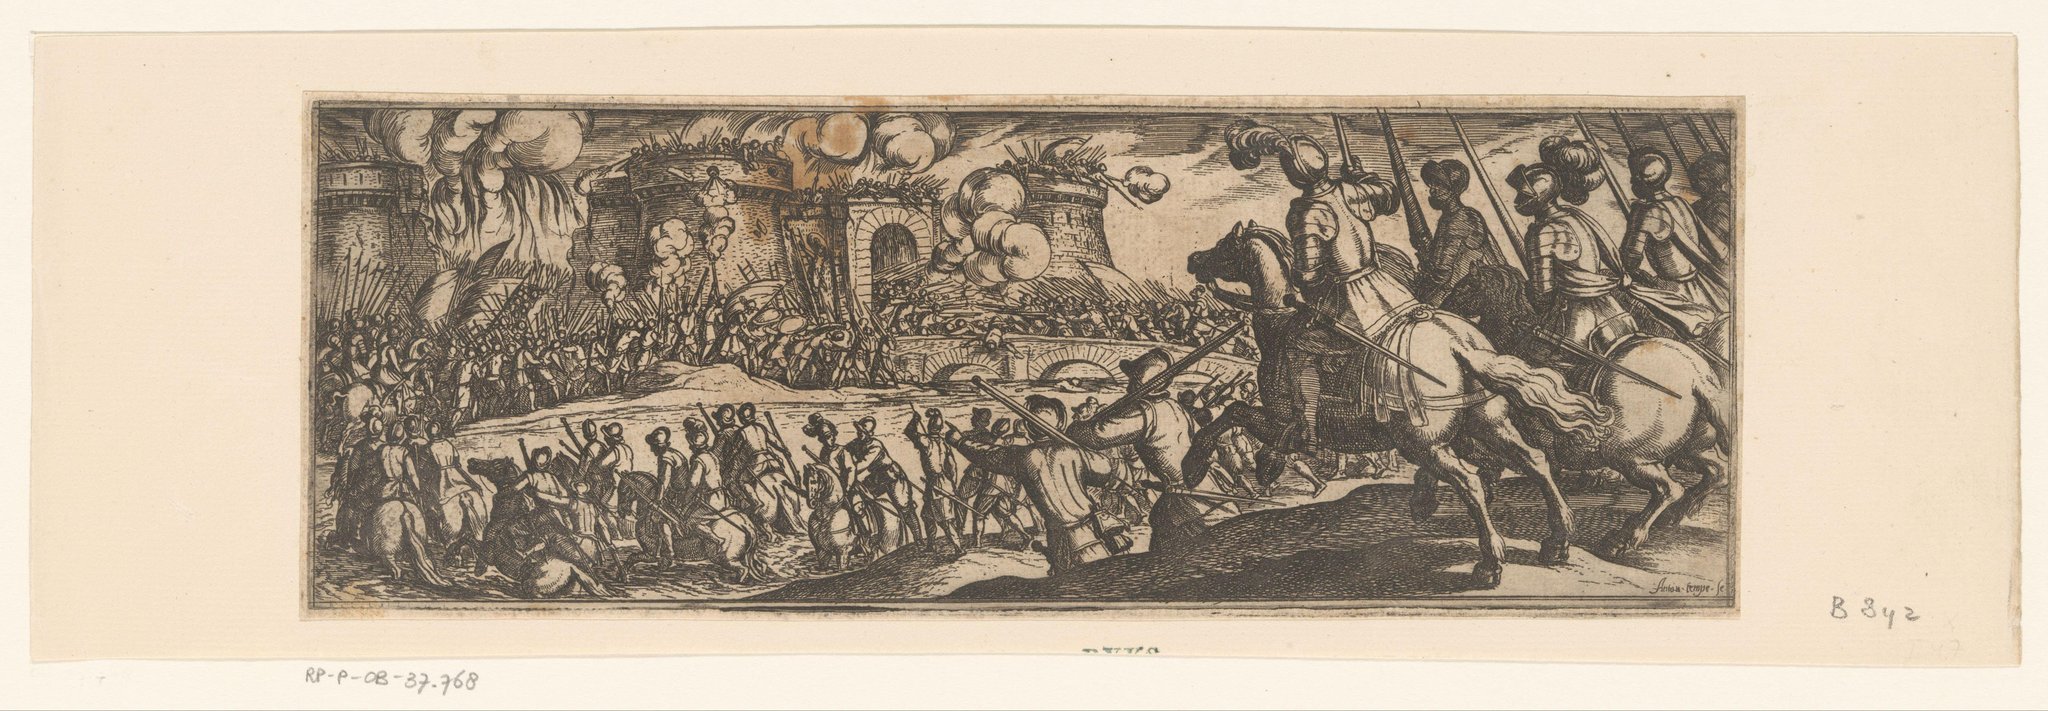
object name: print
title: Leger een fort aanvallend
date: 1599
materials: paper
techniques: etching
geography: italy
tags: battle, warfare; military affairs (+ cavalry, horsemen), the soldier; the soldier's life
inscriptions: collector's mark: Lugt 2165 of 2166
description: Deze prent maakt deel uit van een reeks van 9 prenten (+ titelprent) met gevechtsscènes. Antonio Tempesta maakte ook een eerdere serie met gevechtsscènes van 10 prenten (+titelprent).